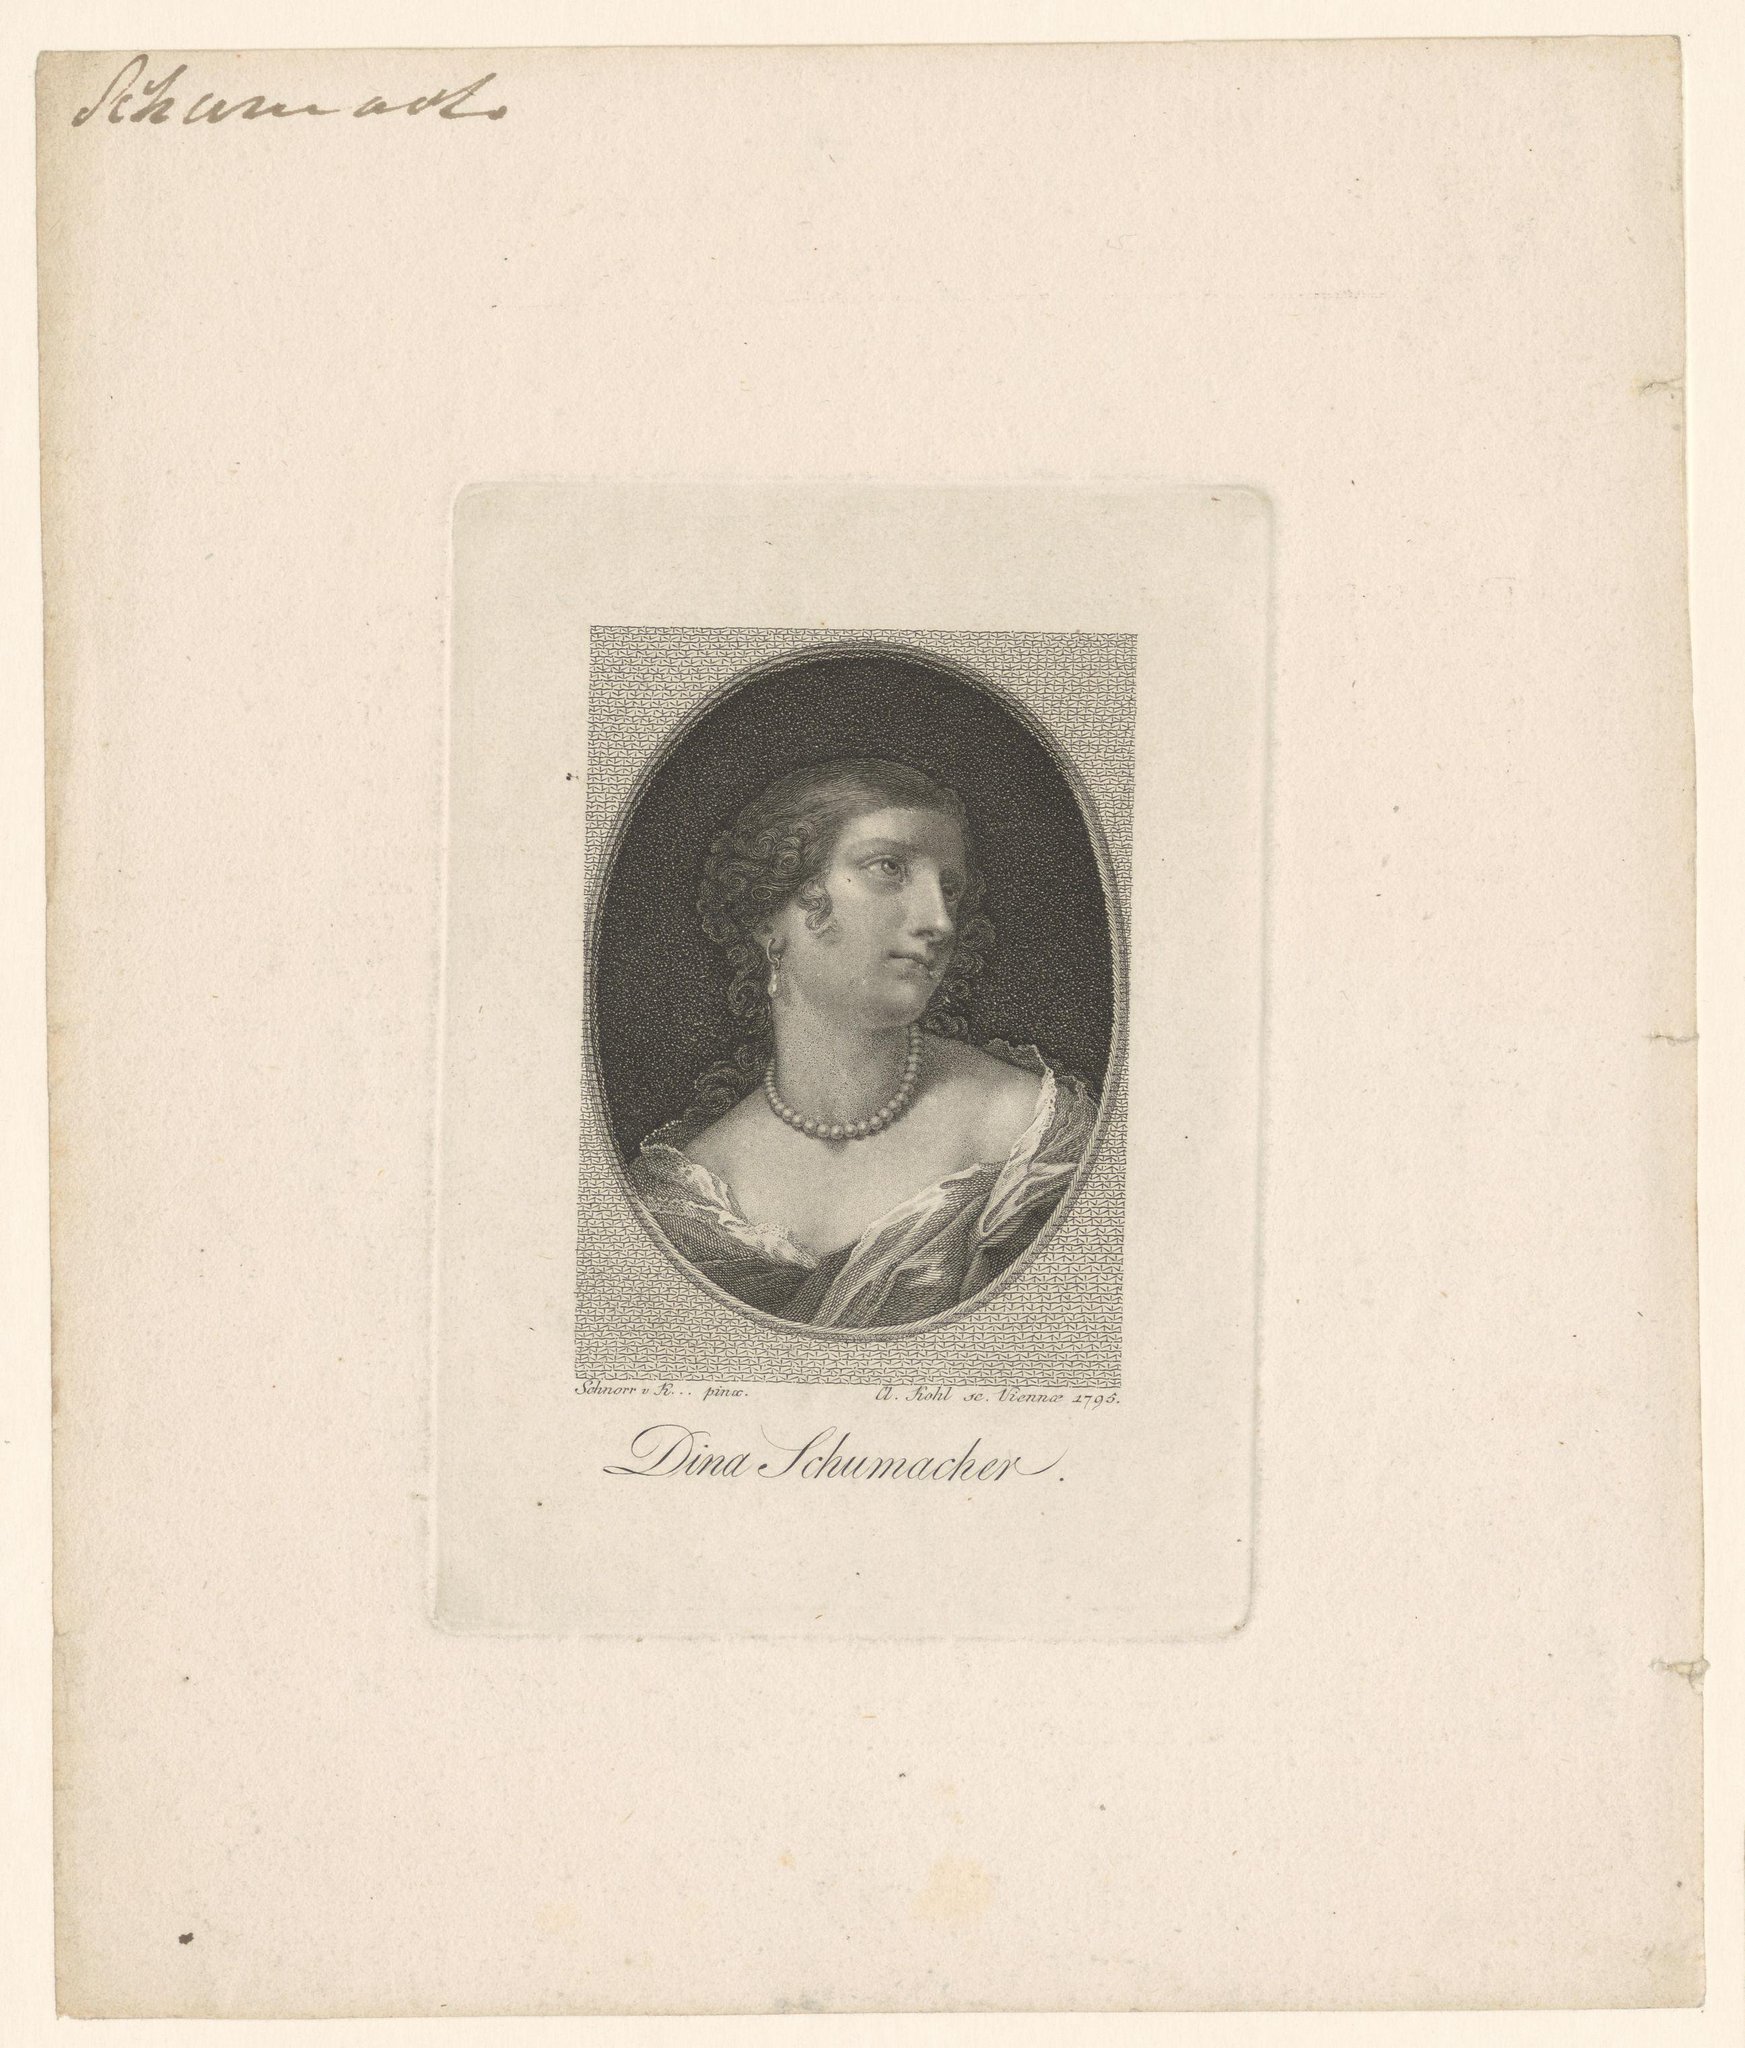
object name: print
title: Portret van Dina Schumacher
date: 1795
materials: paper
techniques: engraving, etching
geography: vienna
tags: (private) detective, historical persons, counsellor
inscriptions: collector's mark: Lugt 2228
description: Geportretteerde ook bekend onder haar meisjesnaam Dina Vinhofvers.